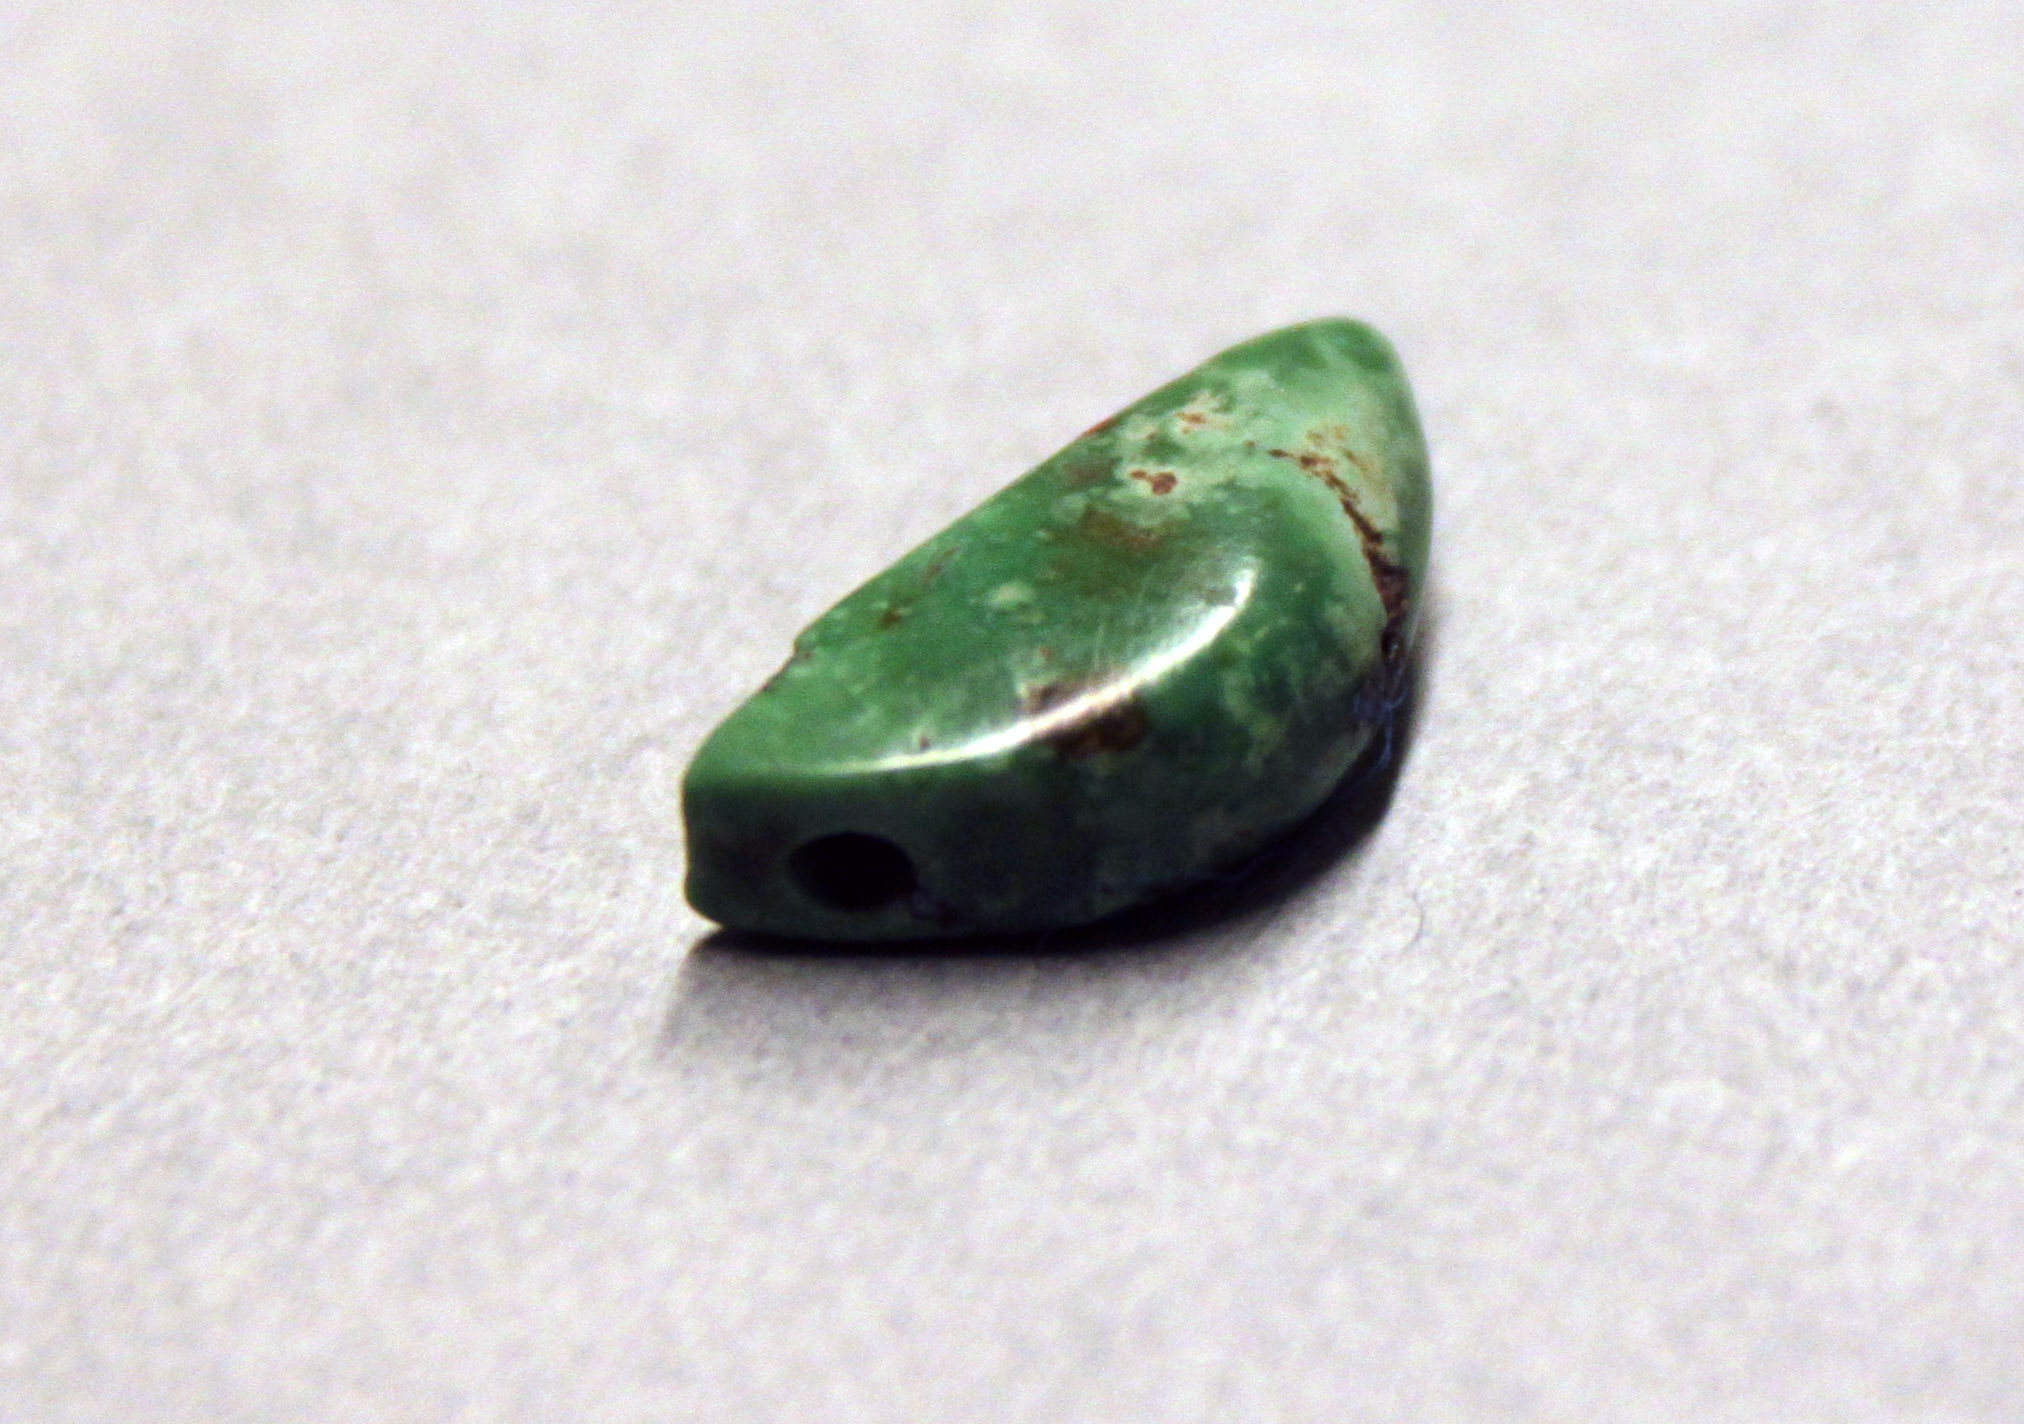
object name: gaming piece or stone object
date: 701-1300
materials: stone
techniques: carving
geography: iran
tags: games